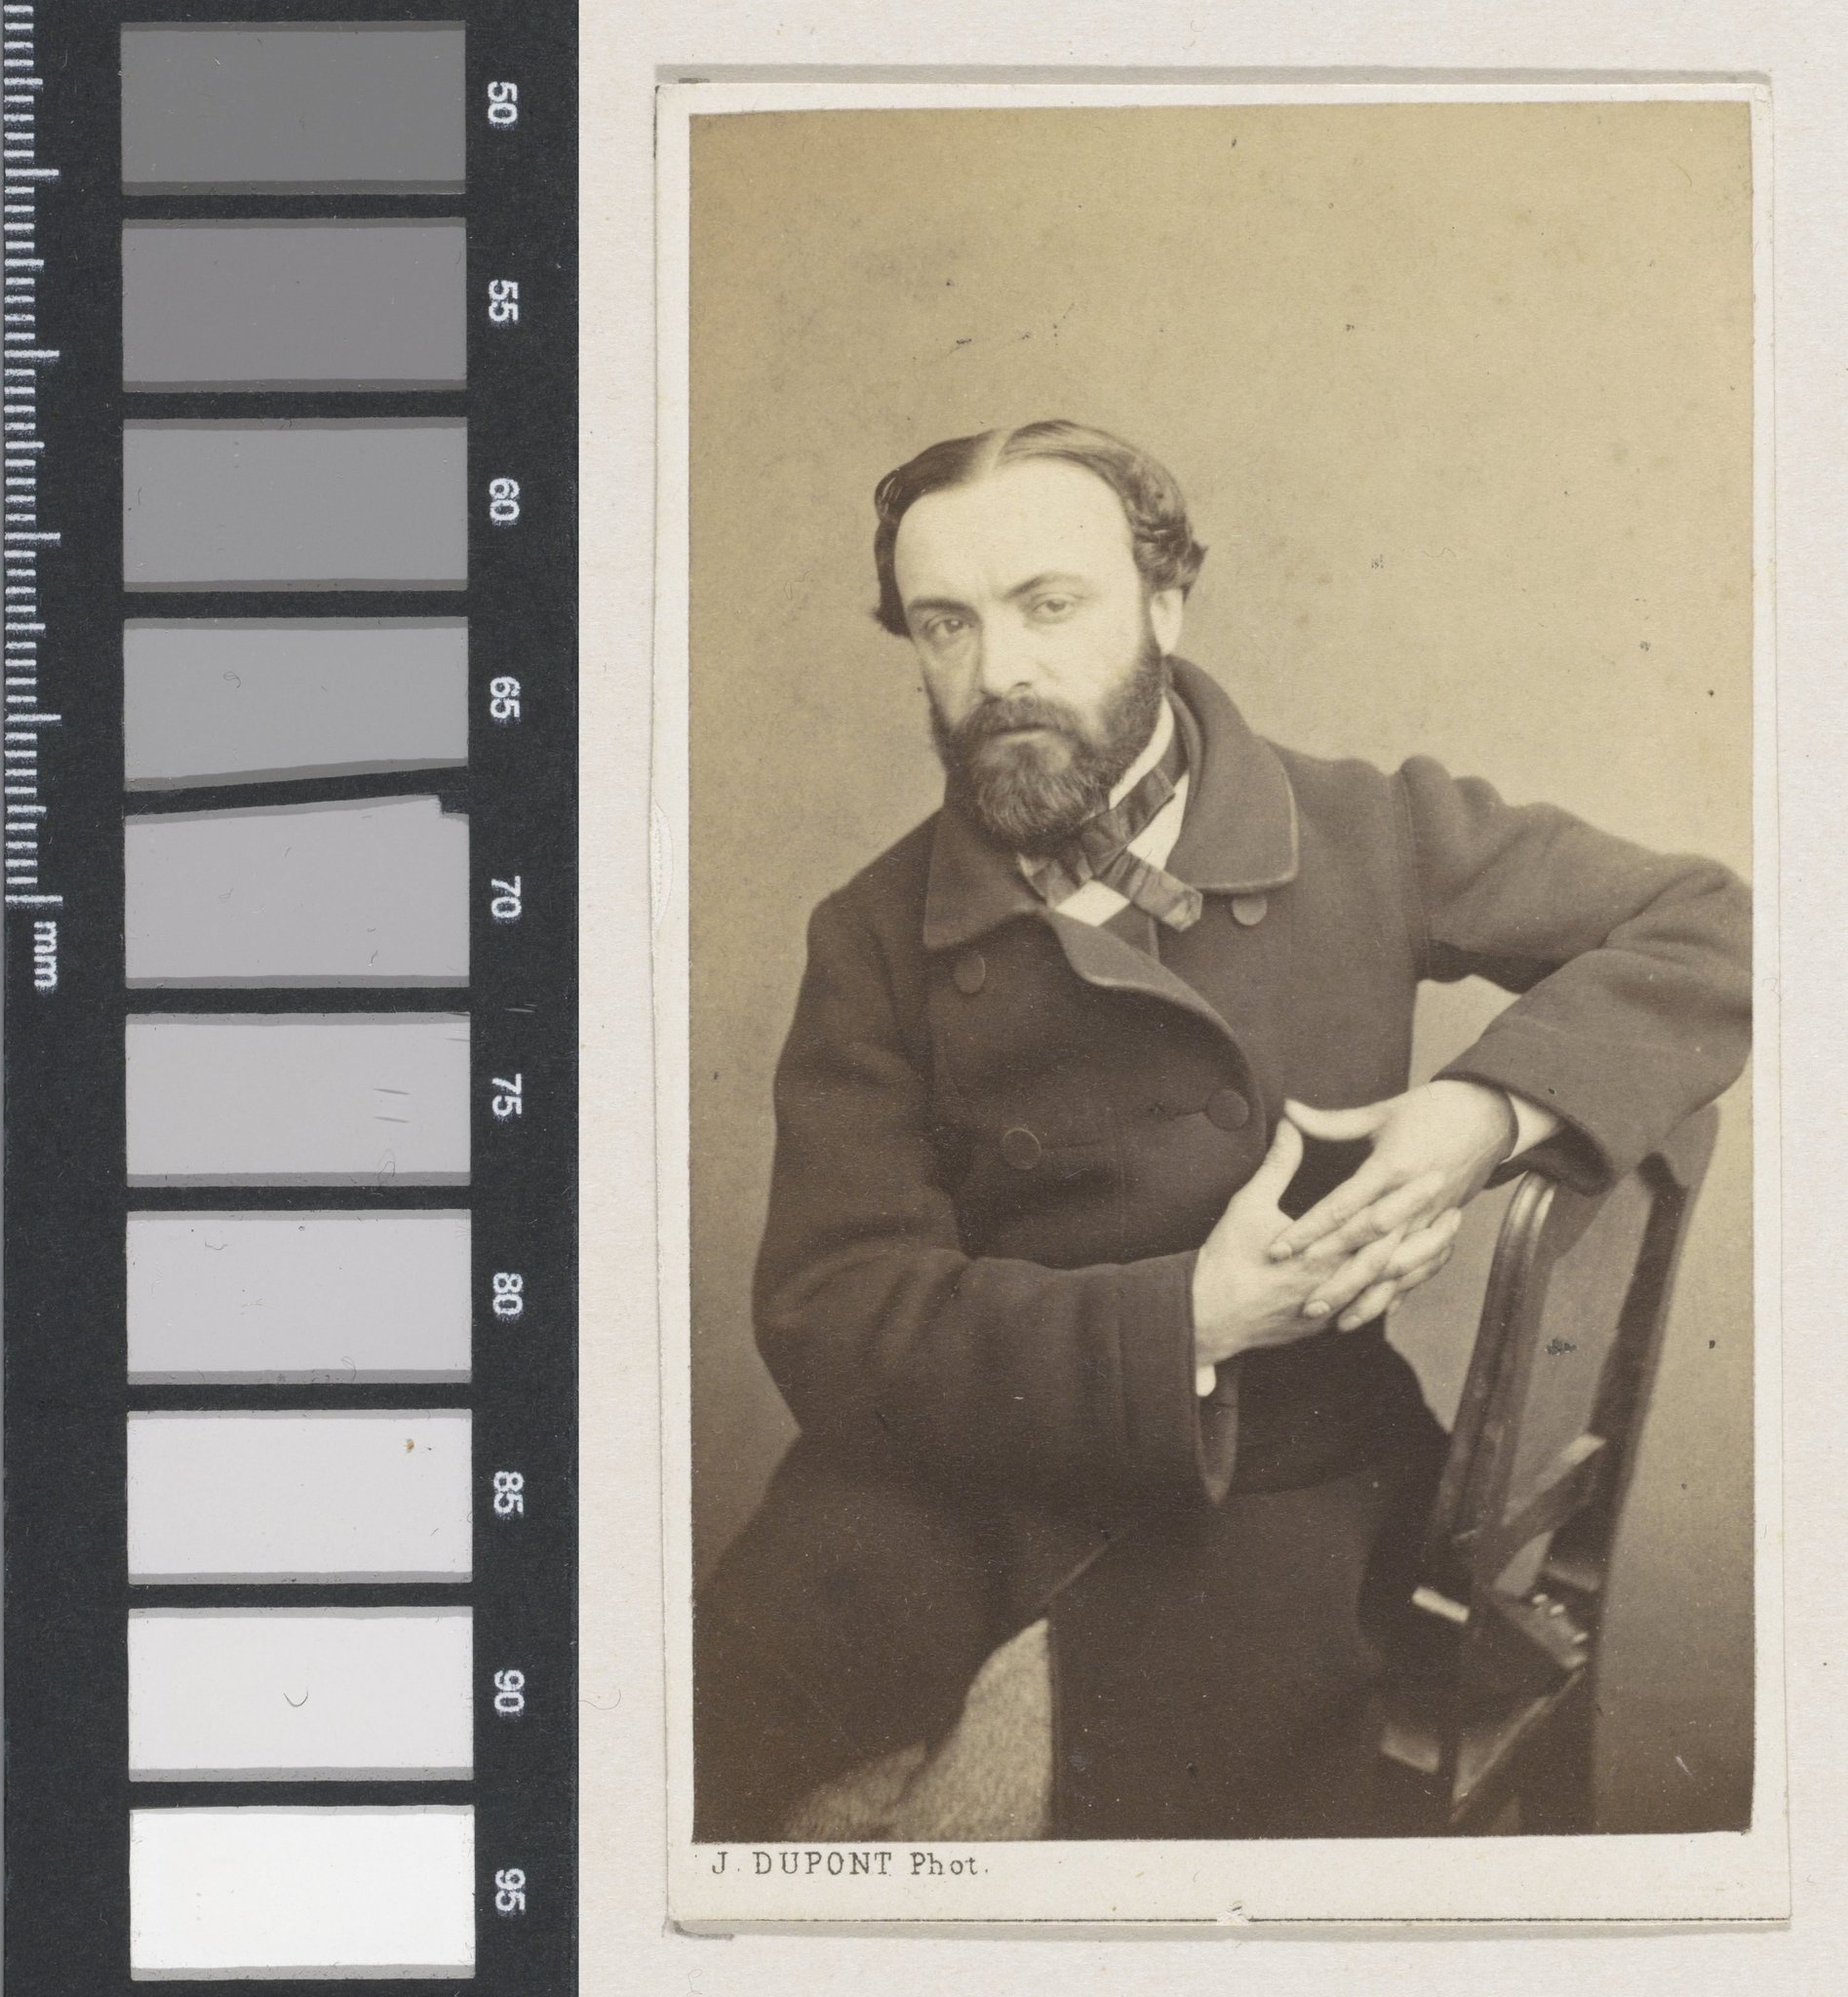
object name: carte de visite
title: L'École d'Anvers. Portraits biographies cartes de visite. Collection Dupont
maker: joseph dupont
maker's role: fotograaf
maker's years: 1818-1901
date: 1861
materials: cardboard, paper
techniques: albumen print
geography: antwerp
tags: painter, print maker, charles verlat, historical persons, portrait, self-portrait of painter, portrait, self-portrait of artist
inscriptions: inscription: ‘ETABLISSEMENT PHOTOGRAPHIQUE/ de/ J. DUPONT/ Place de Meir 32/ ANVERS/ Maison fondée en 1853’, inscription: ‘Verlat’